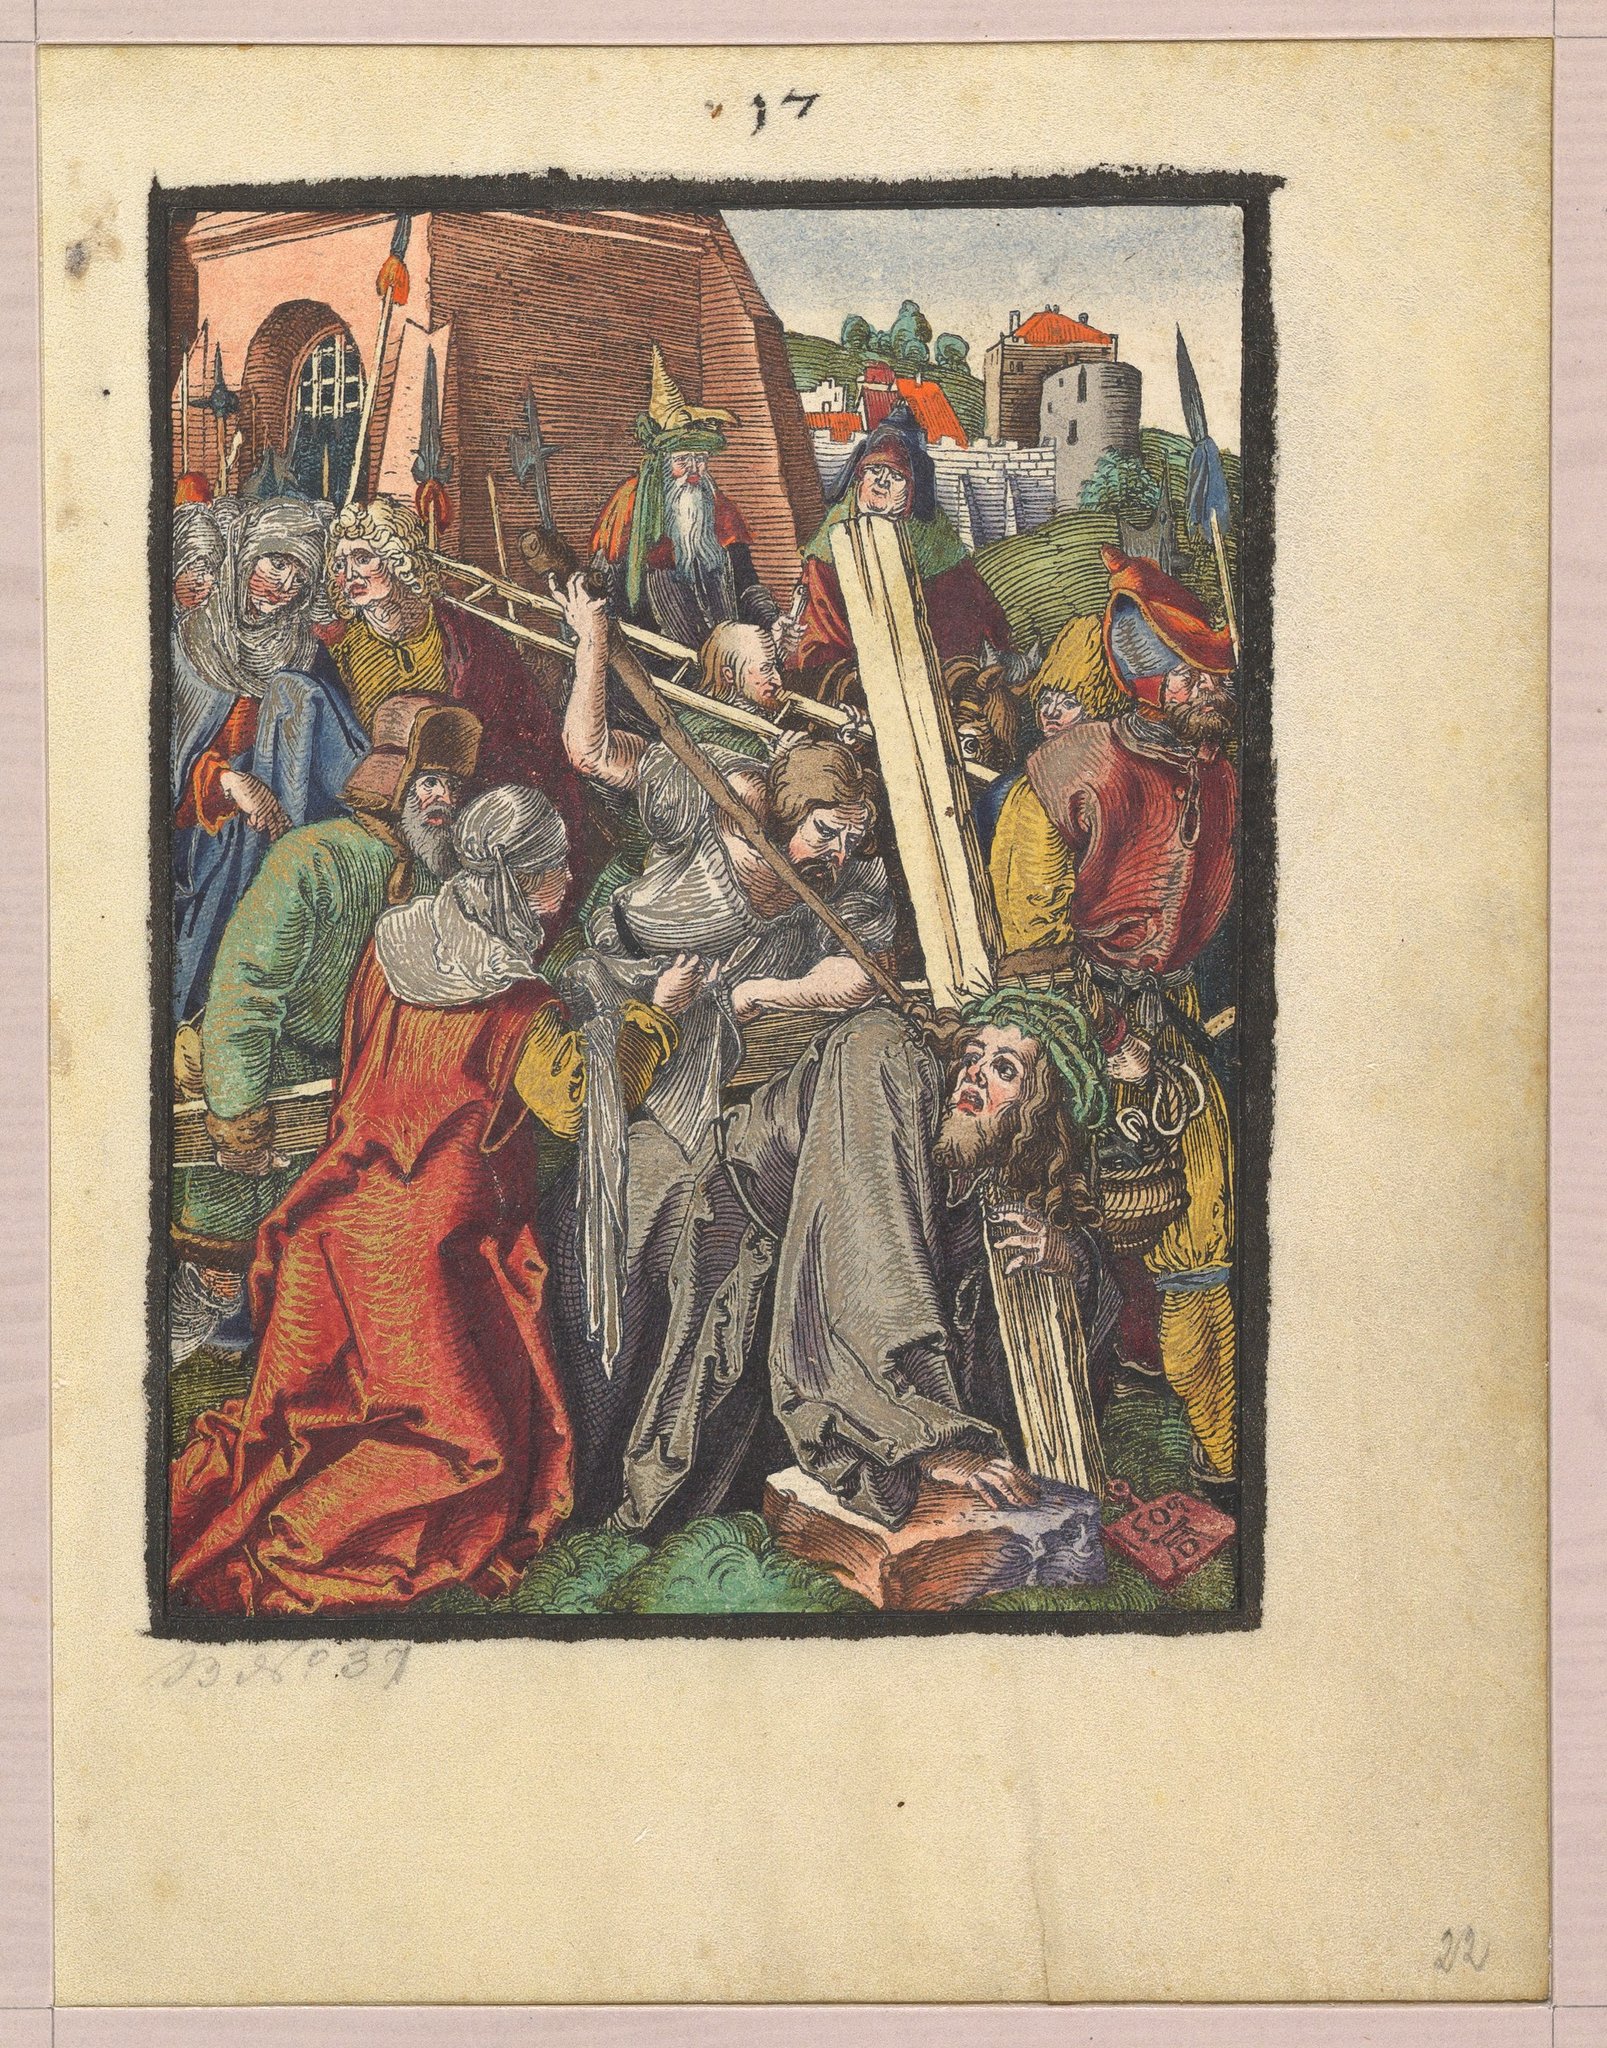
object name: print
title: The Bearing of the Cross, from "The Small Woodcut Passion"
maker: albrecht dürer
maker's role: artist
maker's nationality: german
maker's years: 1471-1528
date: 1509-1510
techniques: hand coloring, woodcut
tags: buildings,weapons,men,women,cross